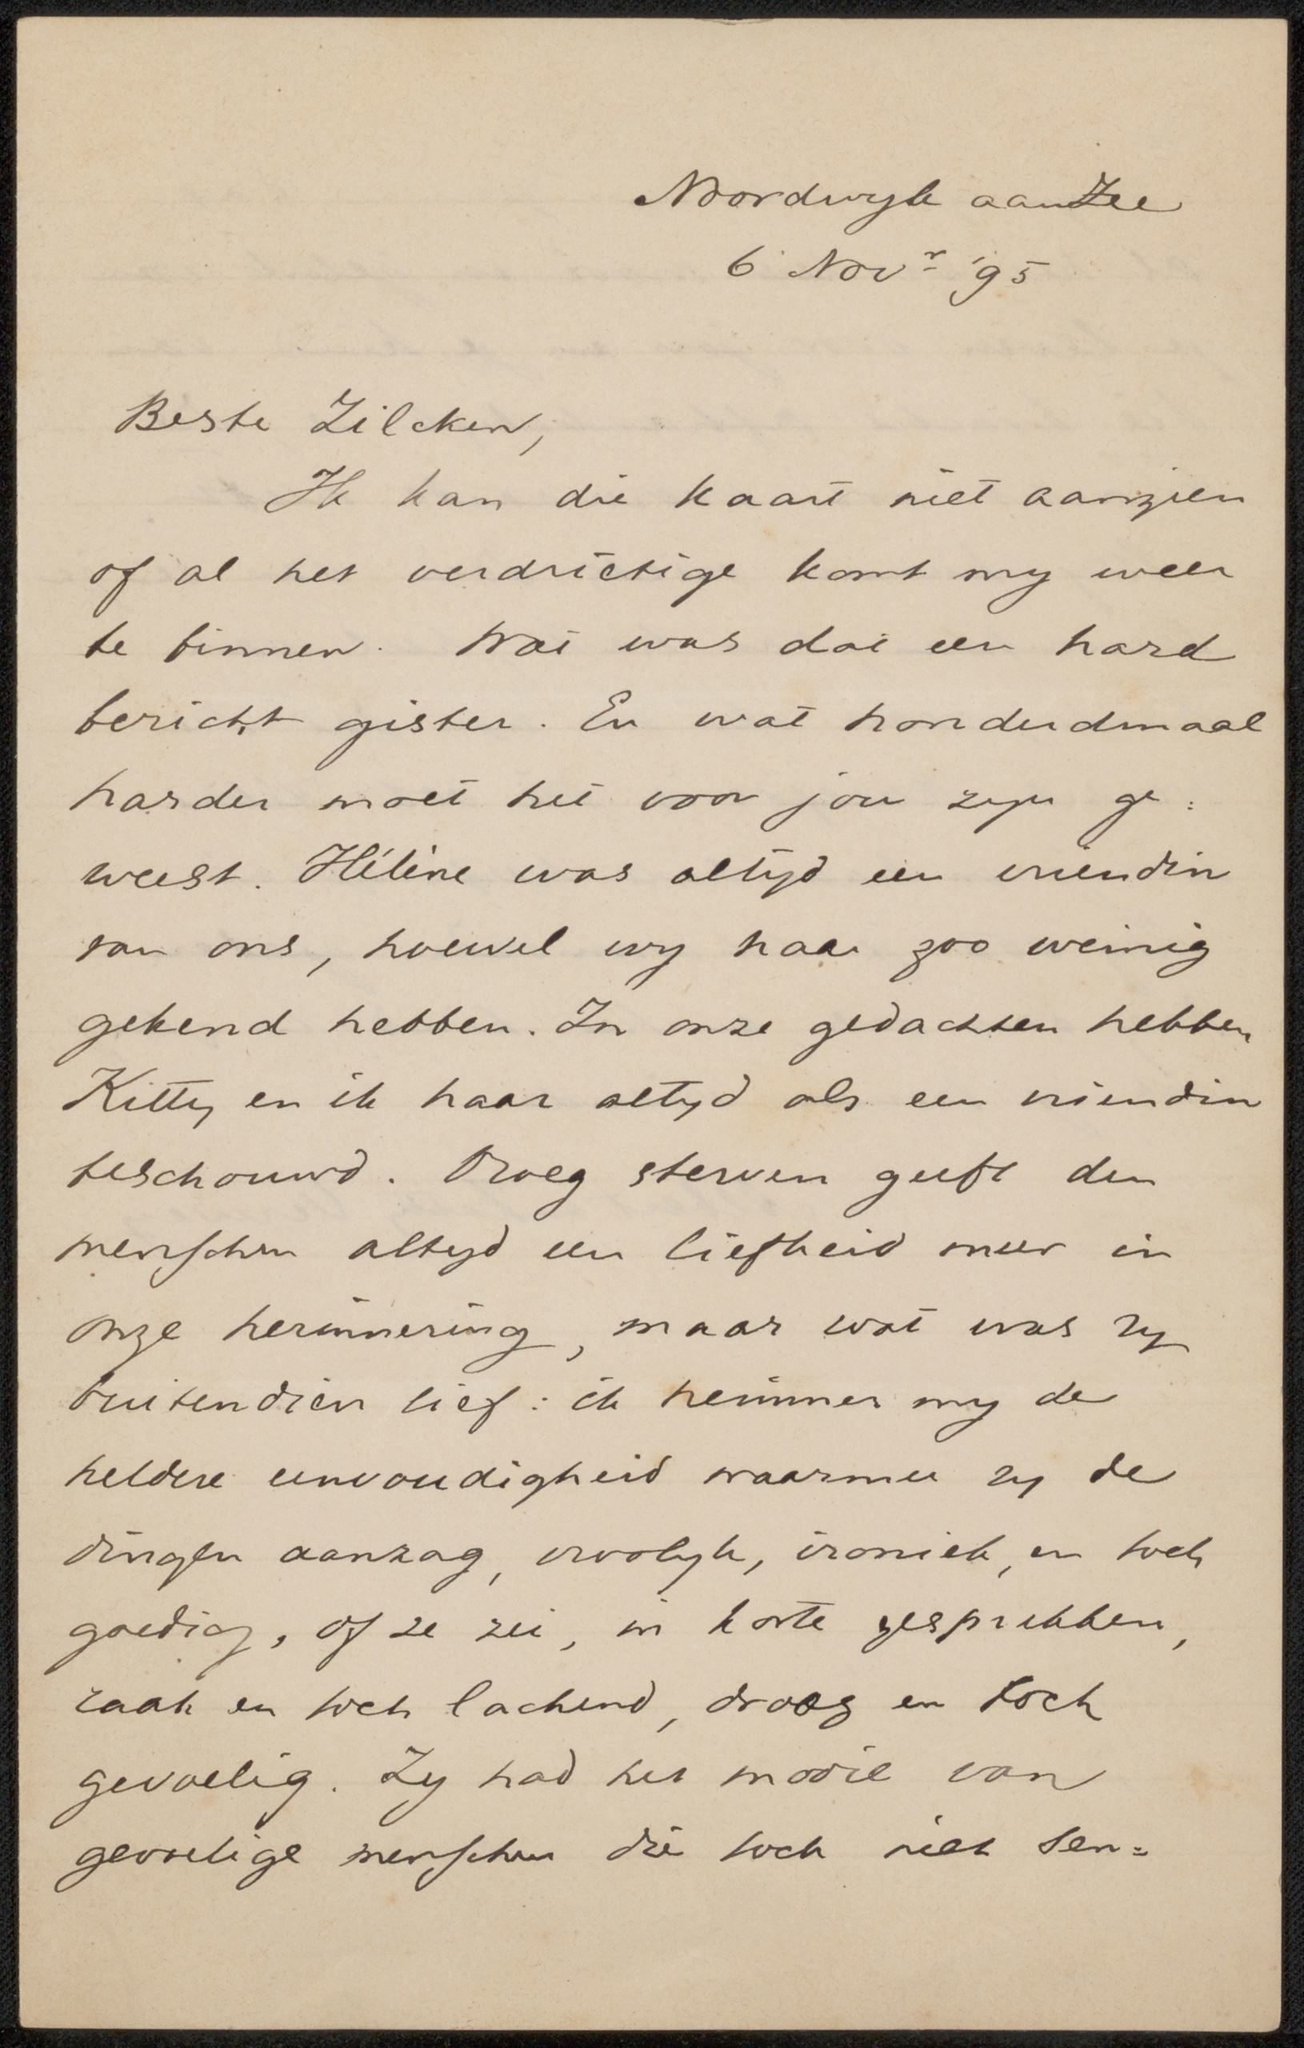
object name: letter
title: Brief aan Philip Zilcken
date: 1895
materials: ink, paper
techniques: pen, writing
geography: noordwijk aan zee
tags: renée hélène laure zilcken, brussels, helène lambertine hauzeur, the hague, painter, draughtsman, philip zilcken, passions, emotions, affections, diseases